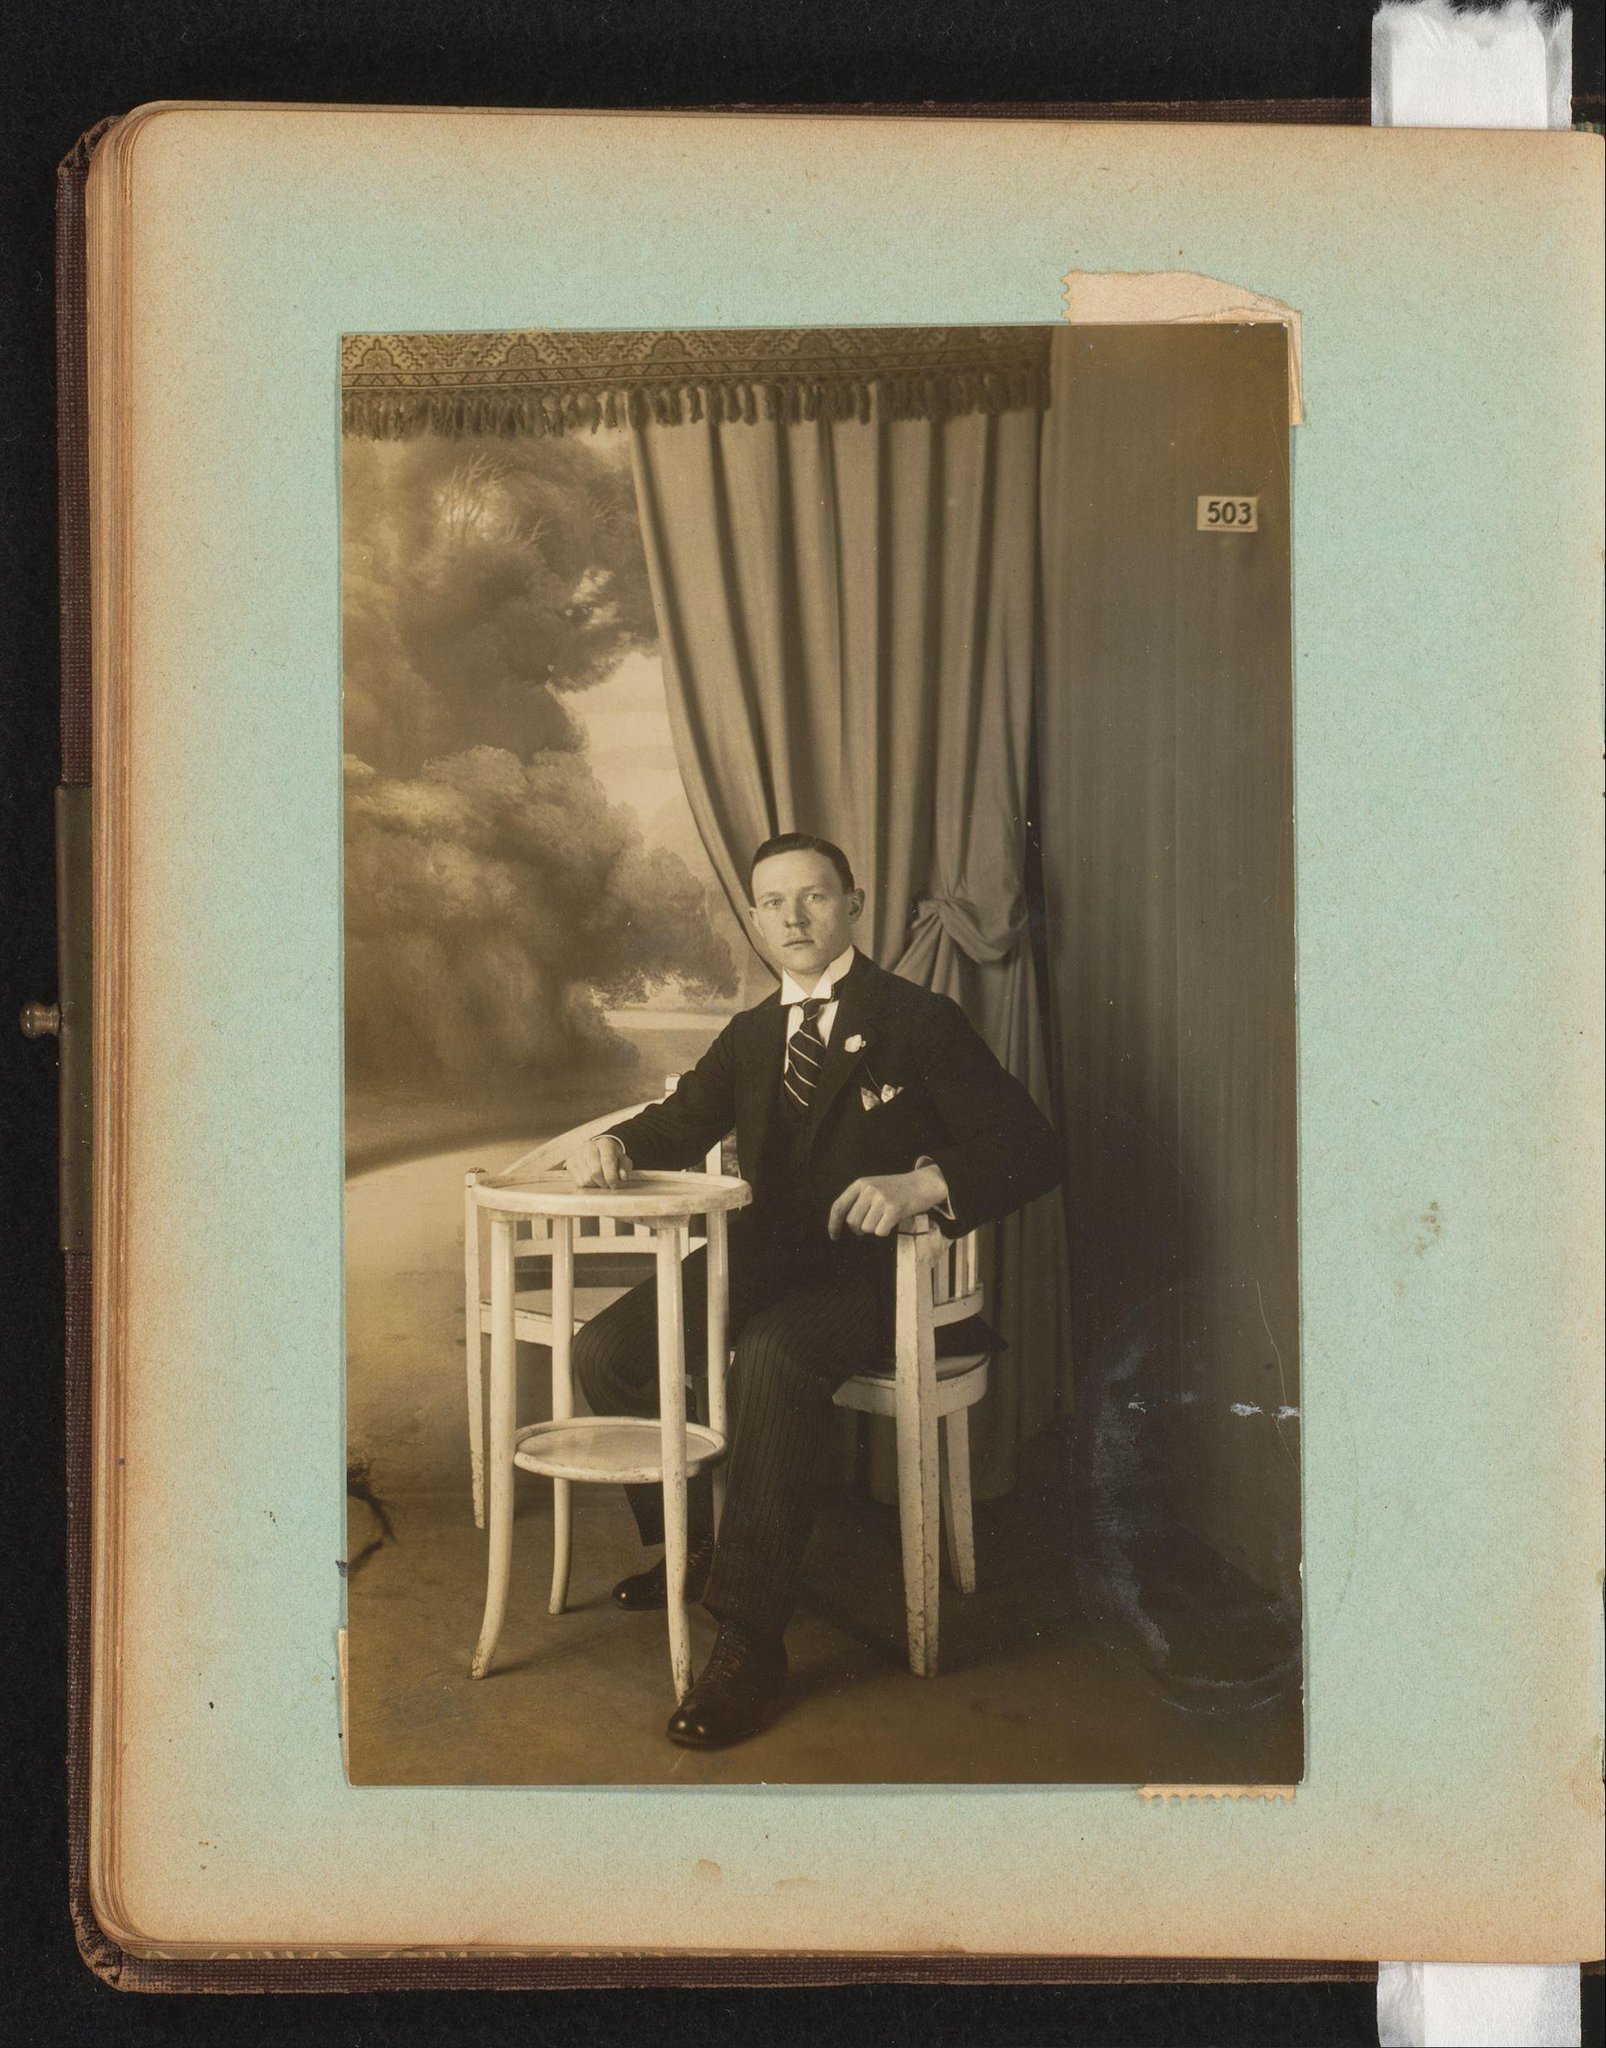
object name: snapshot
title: Portret van een jongeman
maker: Anonymous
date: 1900-1930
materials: photographic support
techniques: gelatin silver print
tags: historical persons, youth, adolescent